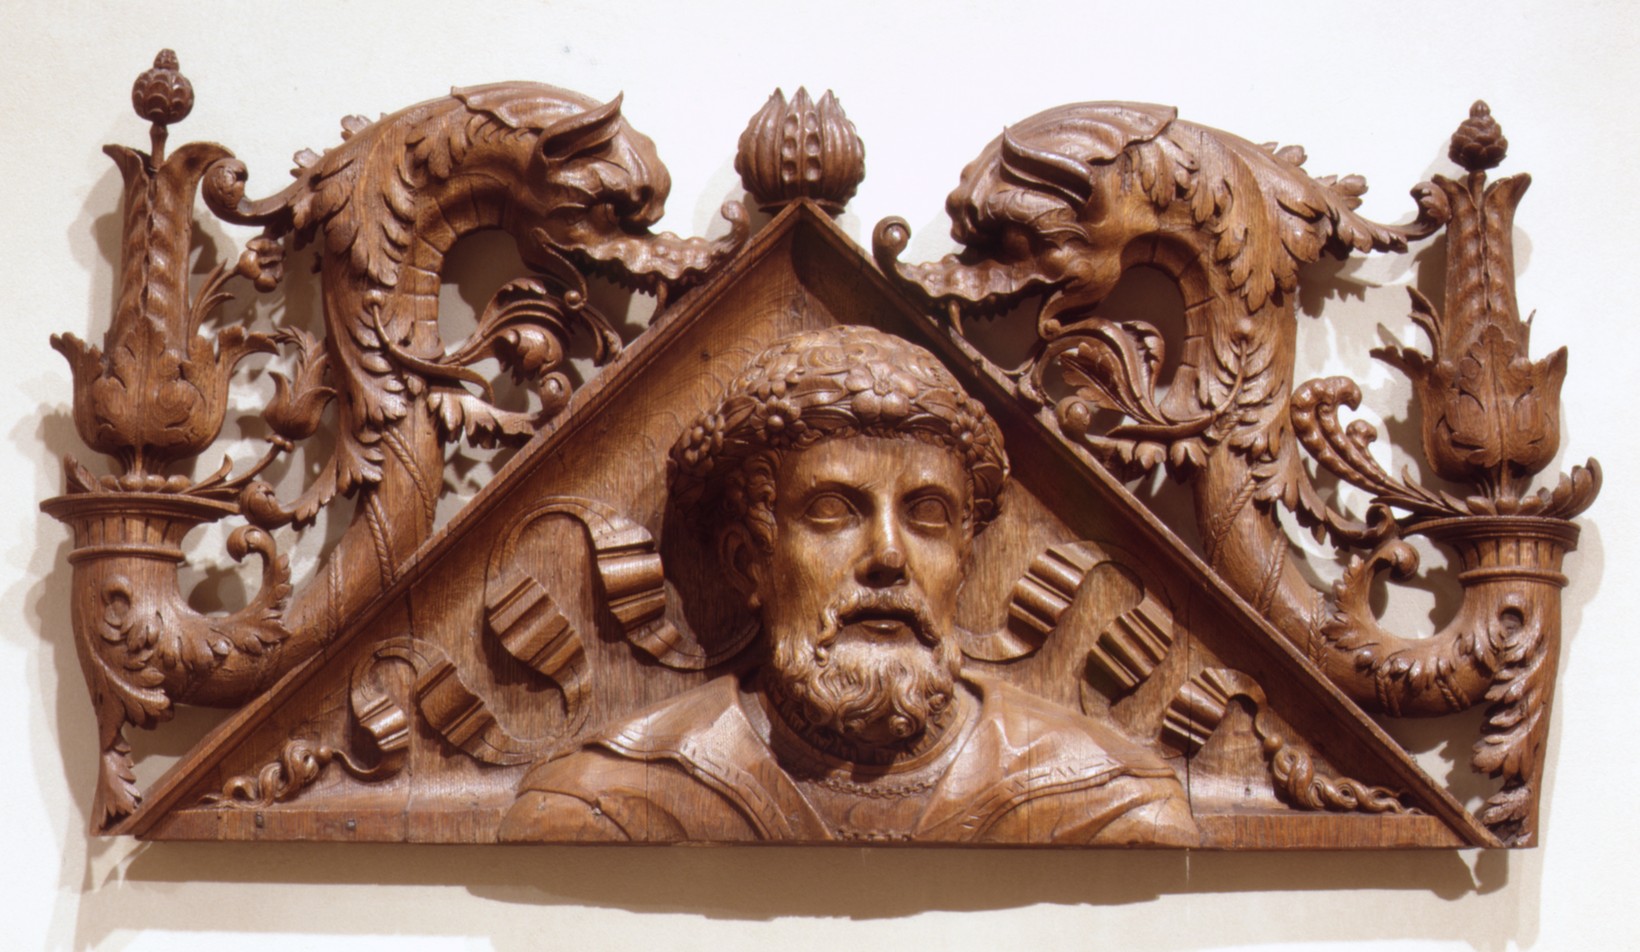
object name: pediment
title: Pediment (one of a pair)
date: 1525-1530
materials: wood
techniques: carving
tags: men